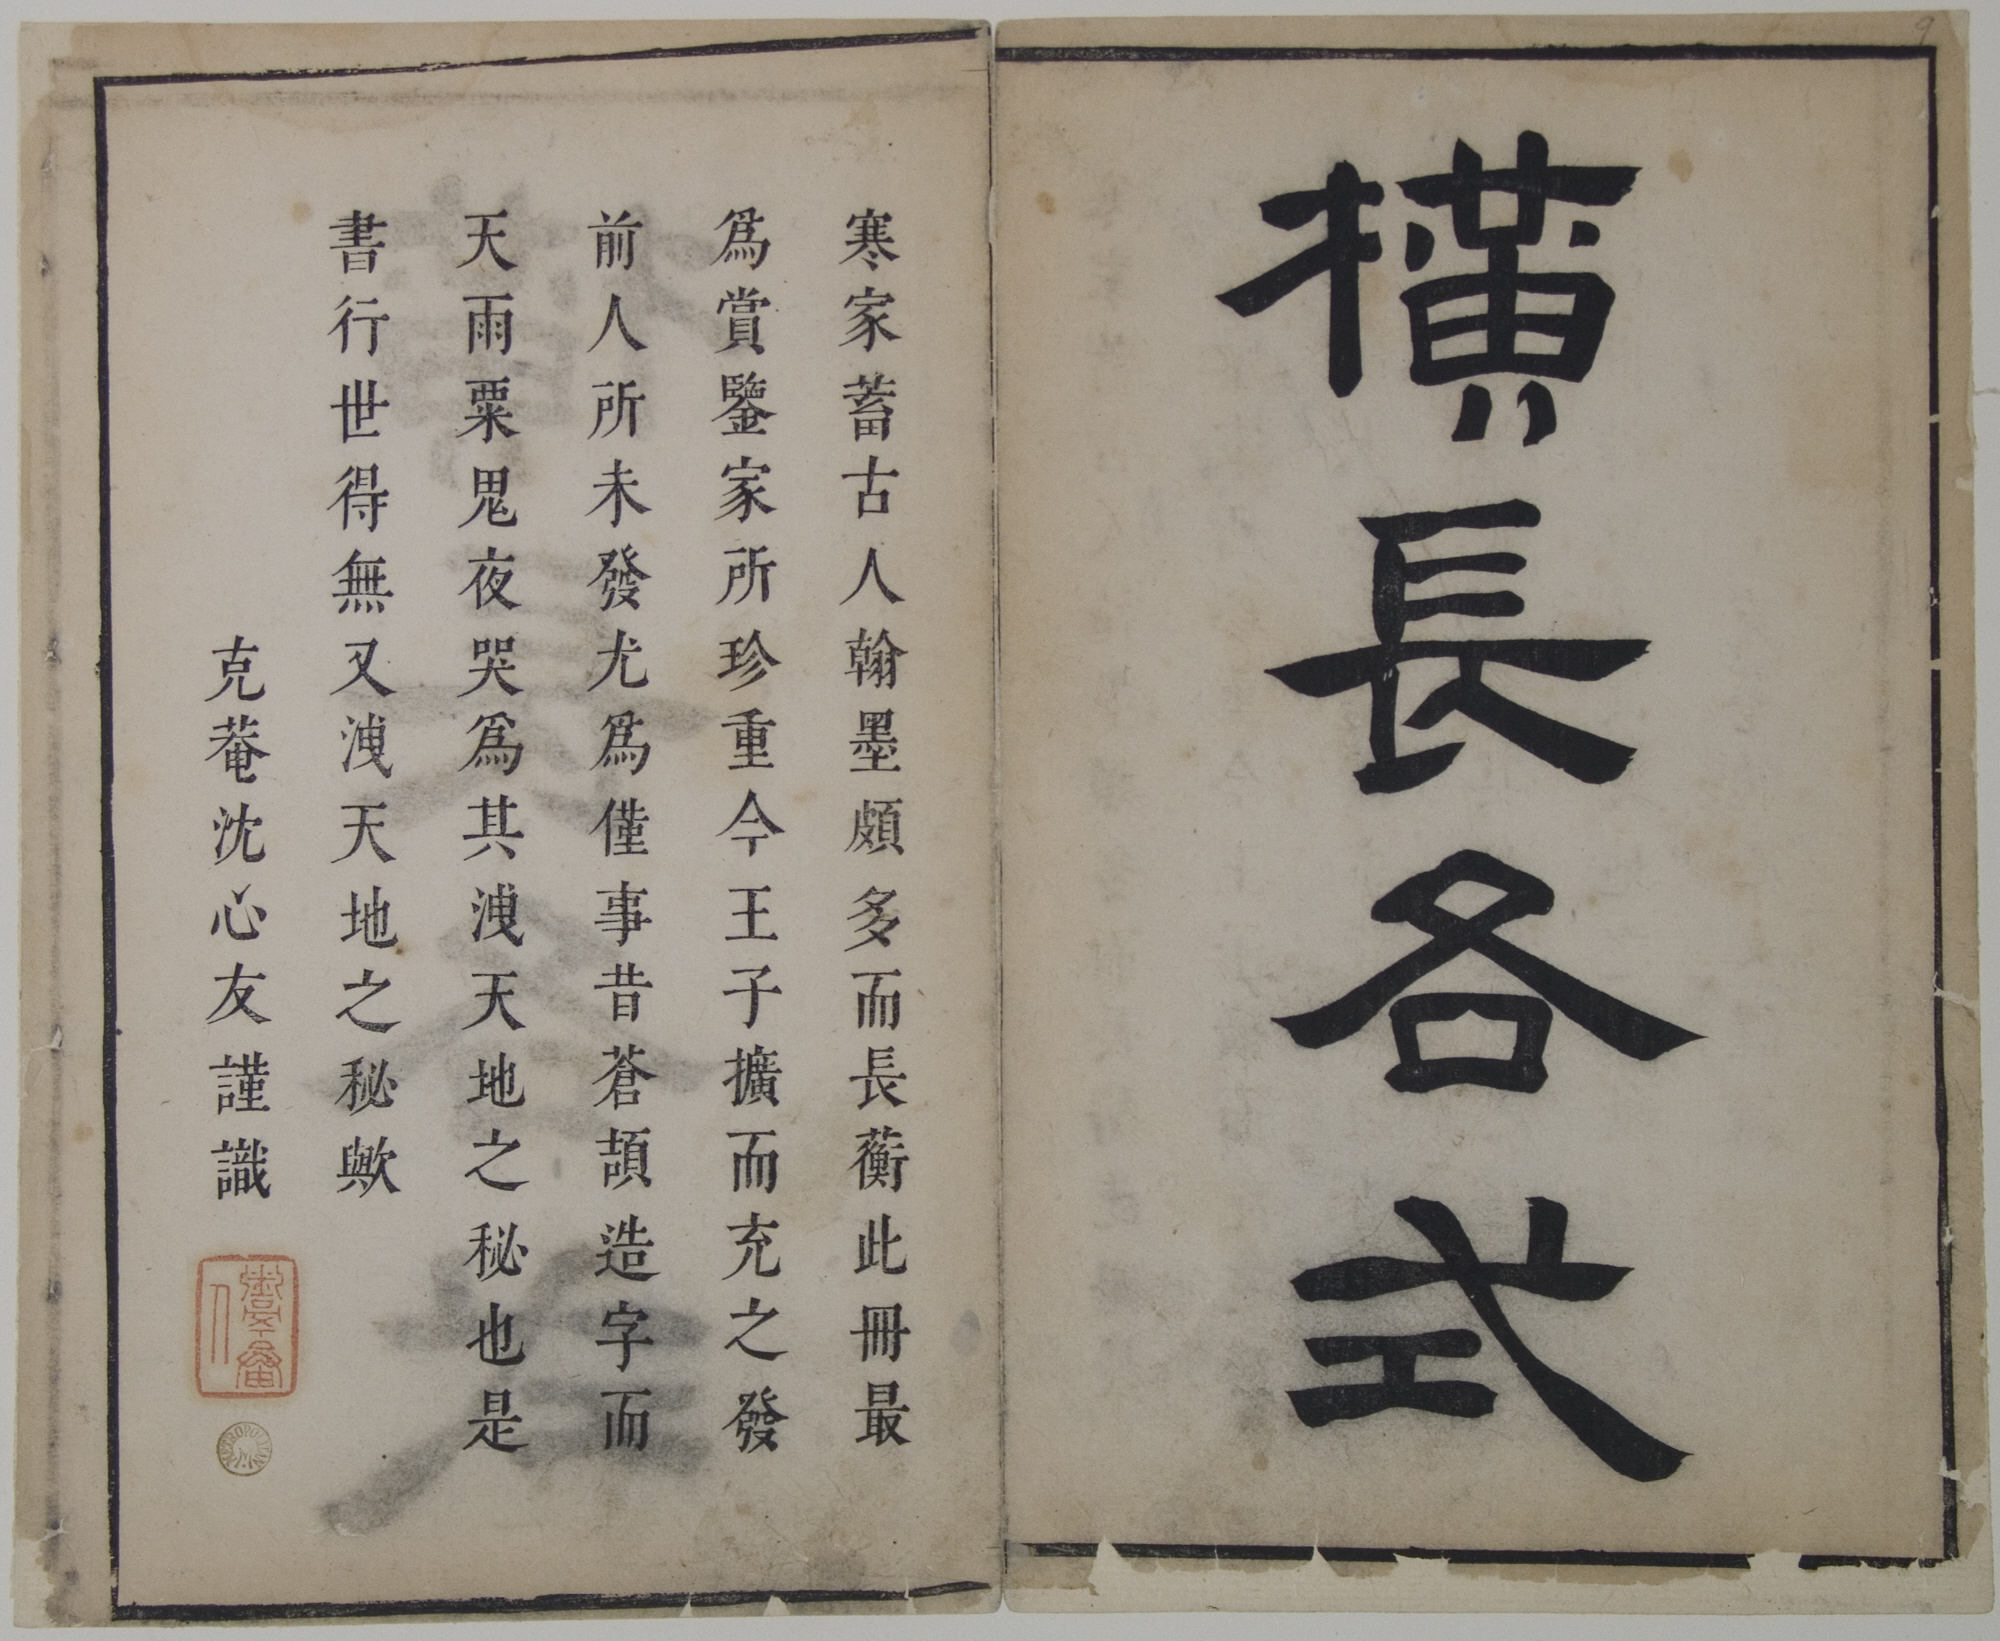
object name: print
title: A Page from the Jie Zi Yuan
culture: chinese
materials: ink, paper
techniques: polychrome, woodblock print